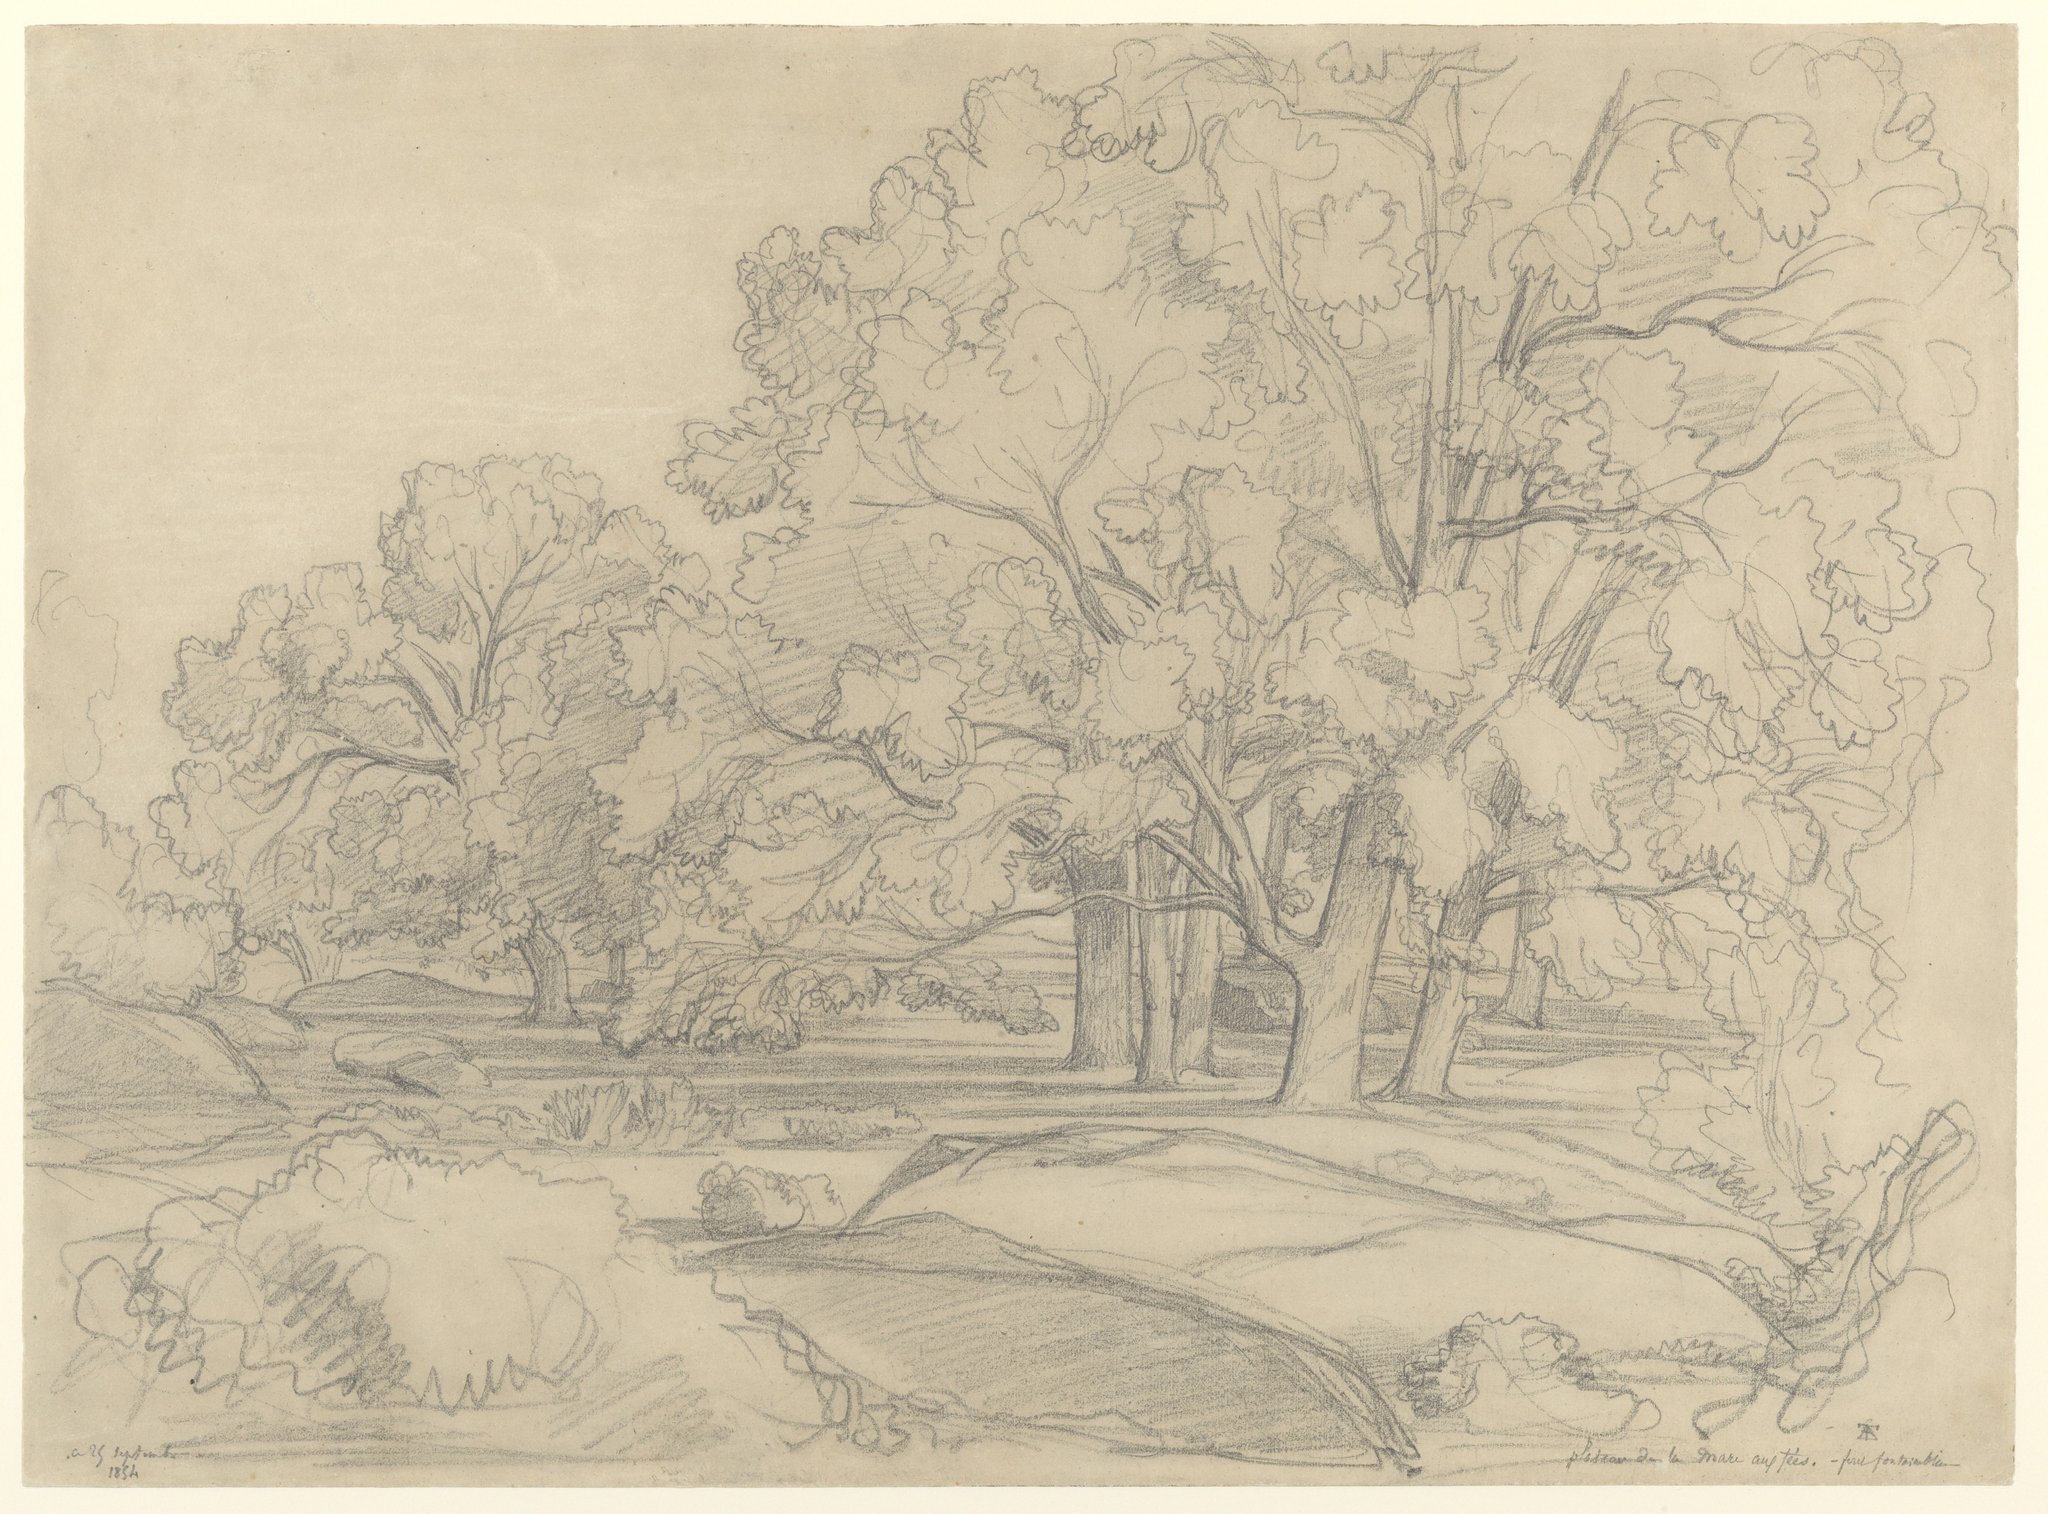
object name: drawing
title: Plateau de la Mare aux Fées (Forest of Fontainebleau)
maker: théodore caruelle d'aligny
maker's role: artist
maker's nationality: french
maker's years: 1798-1871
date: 1854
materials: graphite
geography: france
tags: forests